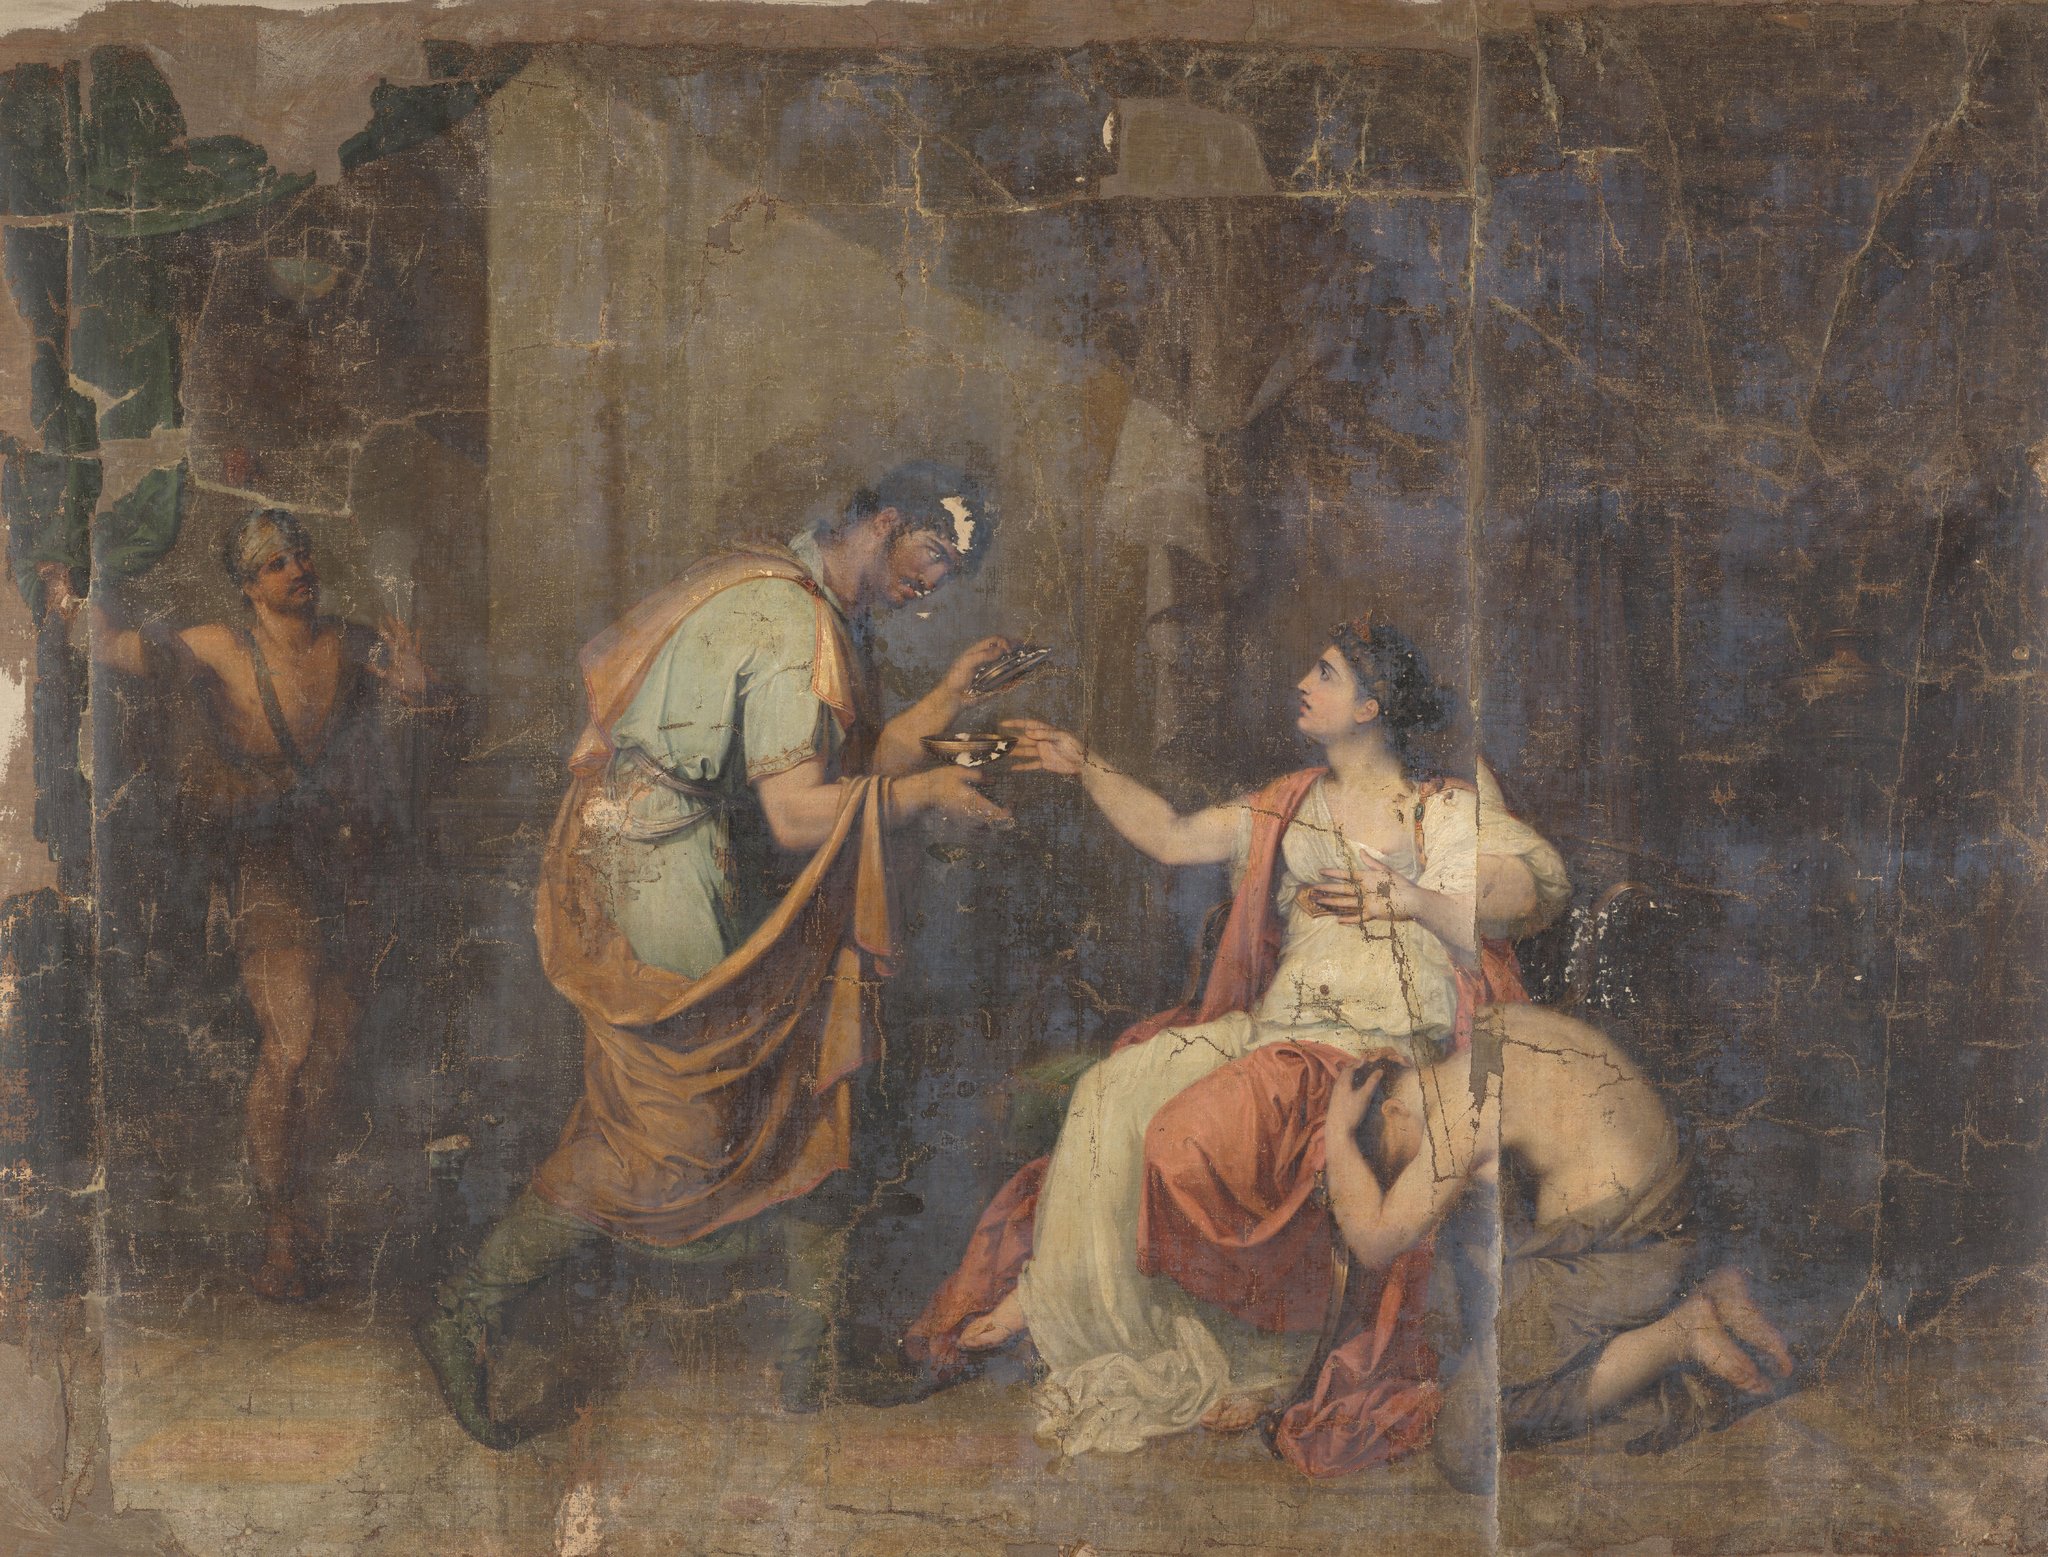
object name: painting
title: The Death of Sophonisbe, Queen of Numidia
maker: benjamin wolff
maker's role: draughtsman, painter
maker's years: 1758-1825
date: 1816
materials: canvas, oil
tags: death of sophonisbe: she receives from a servant a cup of poison sent to her by masinissa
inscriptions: signature and date: ‘Wolff f 1816’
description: De dood van Sophonisba, koningin van Numidië. Sophonisba neemt de gifbeker in ontvangst, naast haar knielt een dienaar (zie ook SK-A-659).